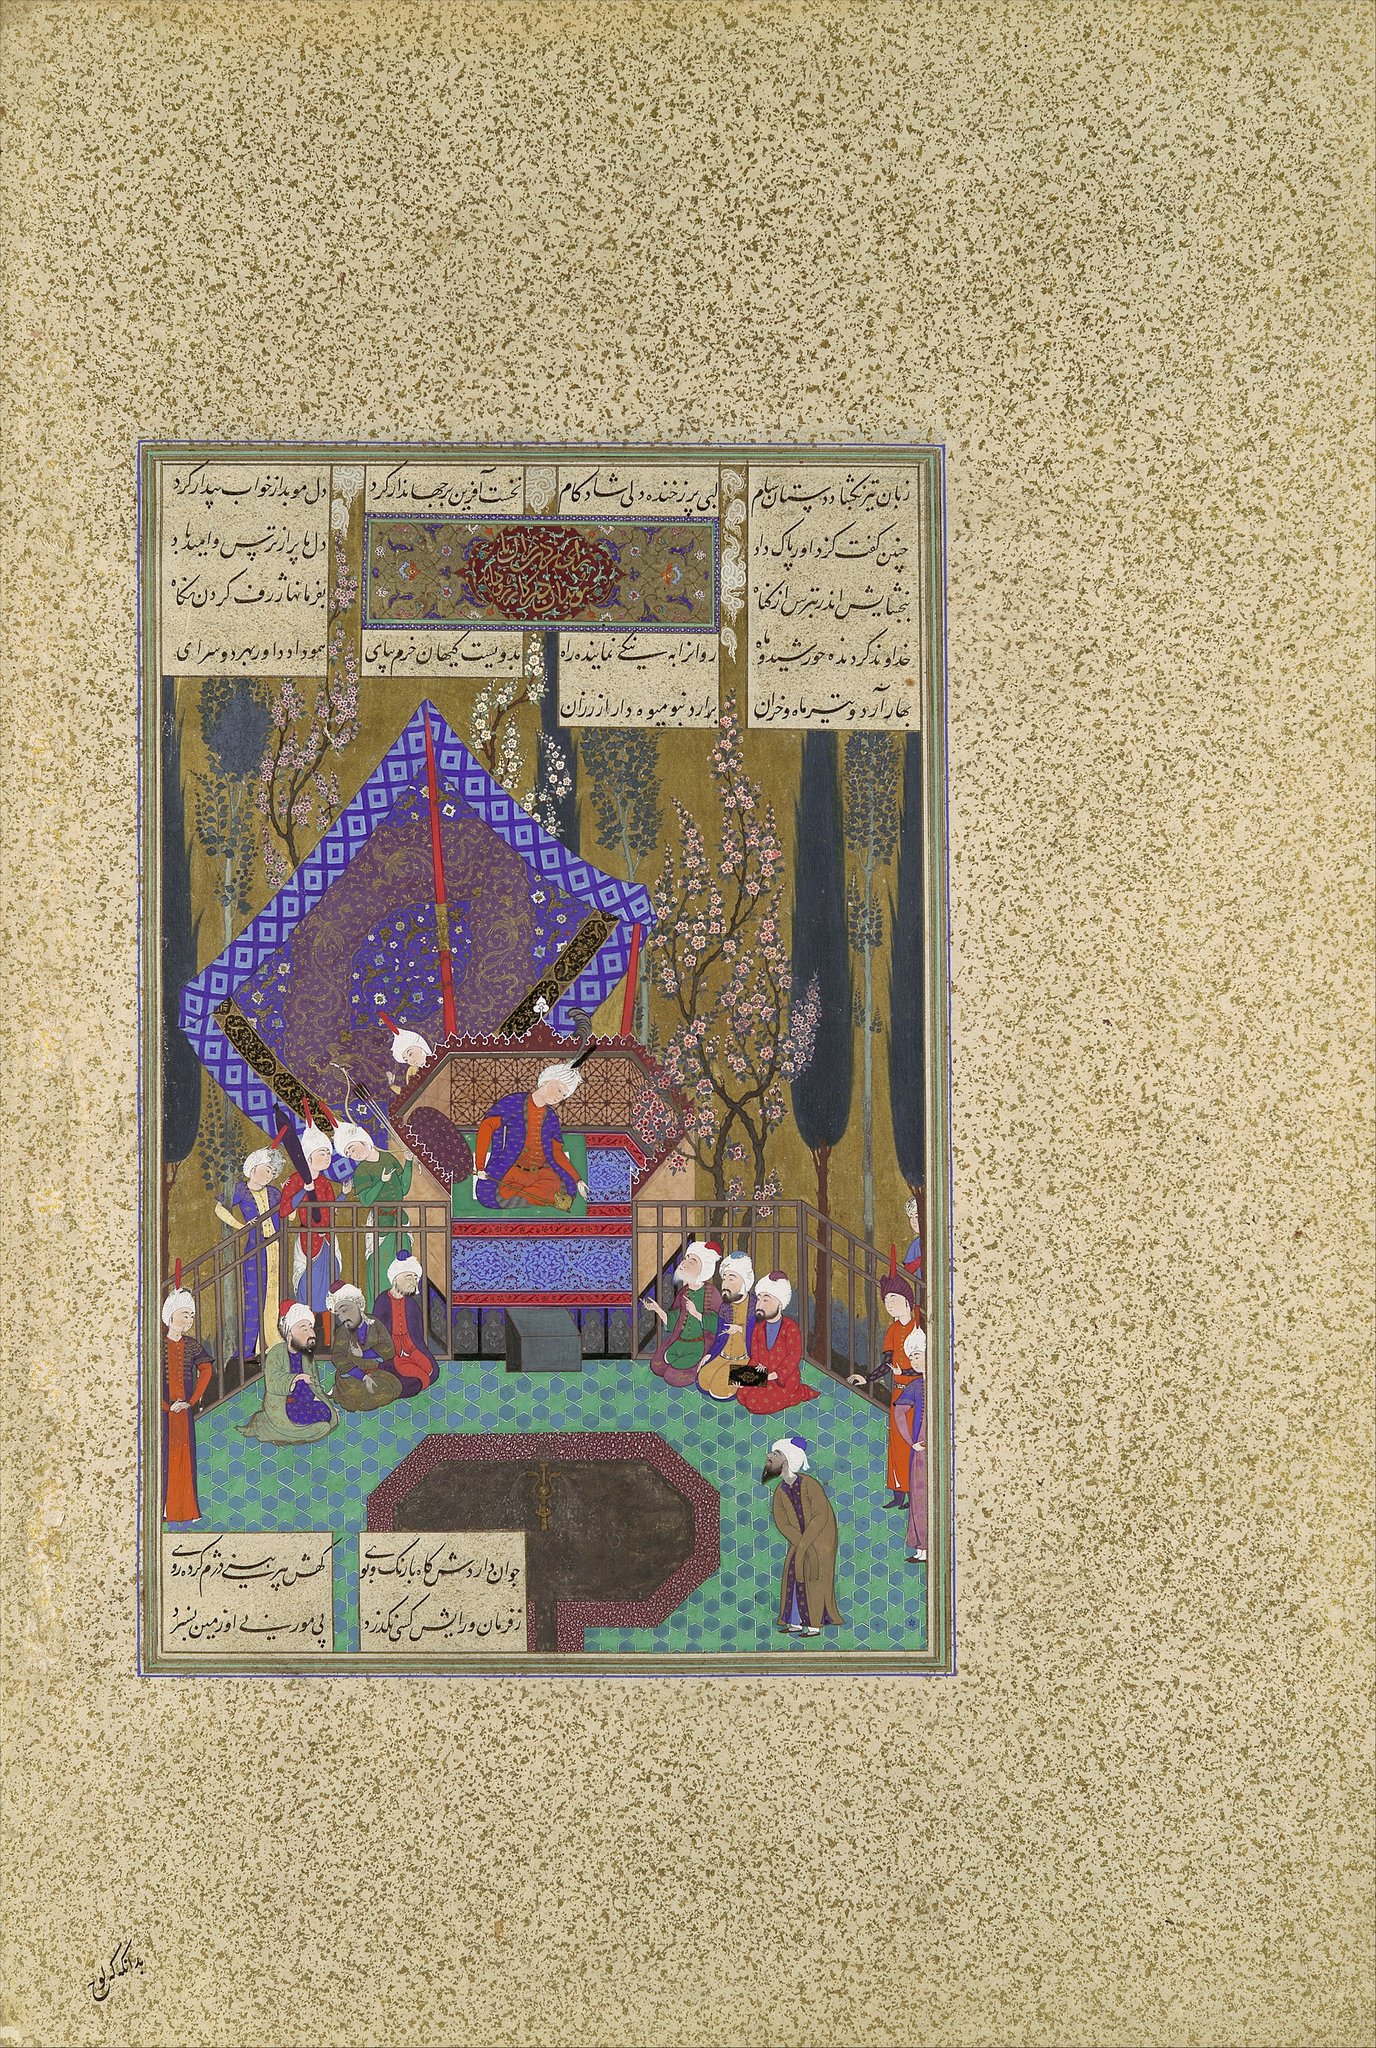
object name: folio from an illustrated manuscript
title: "Zal Consults the Magi", Folio 73v from the Shahnama (Book of Kings) of Shah Tahmasp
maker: abu'l qasim firdausi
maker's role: author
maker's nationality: iranian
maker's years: 935-1020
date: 1530-1535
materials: gold, ink, paper, silver, watercolor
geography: iran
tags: kings,men,trees